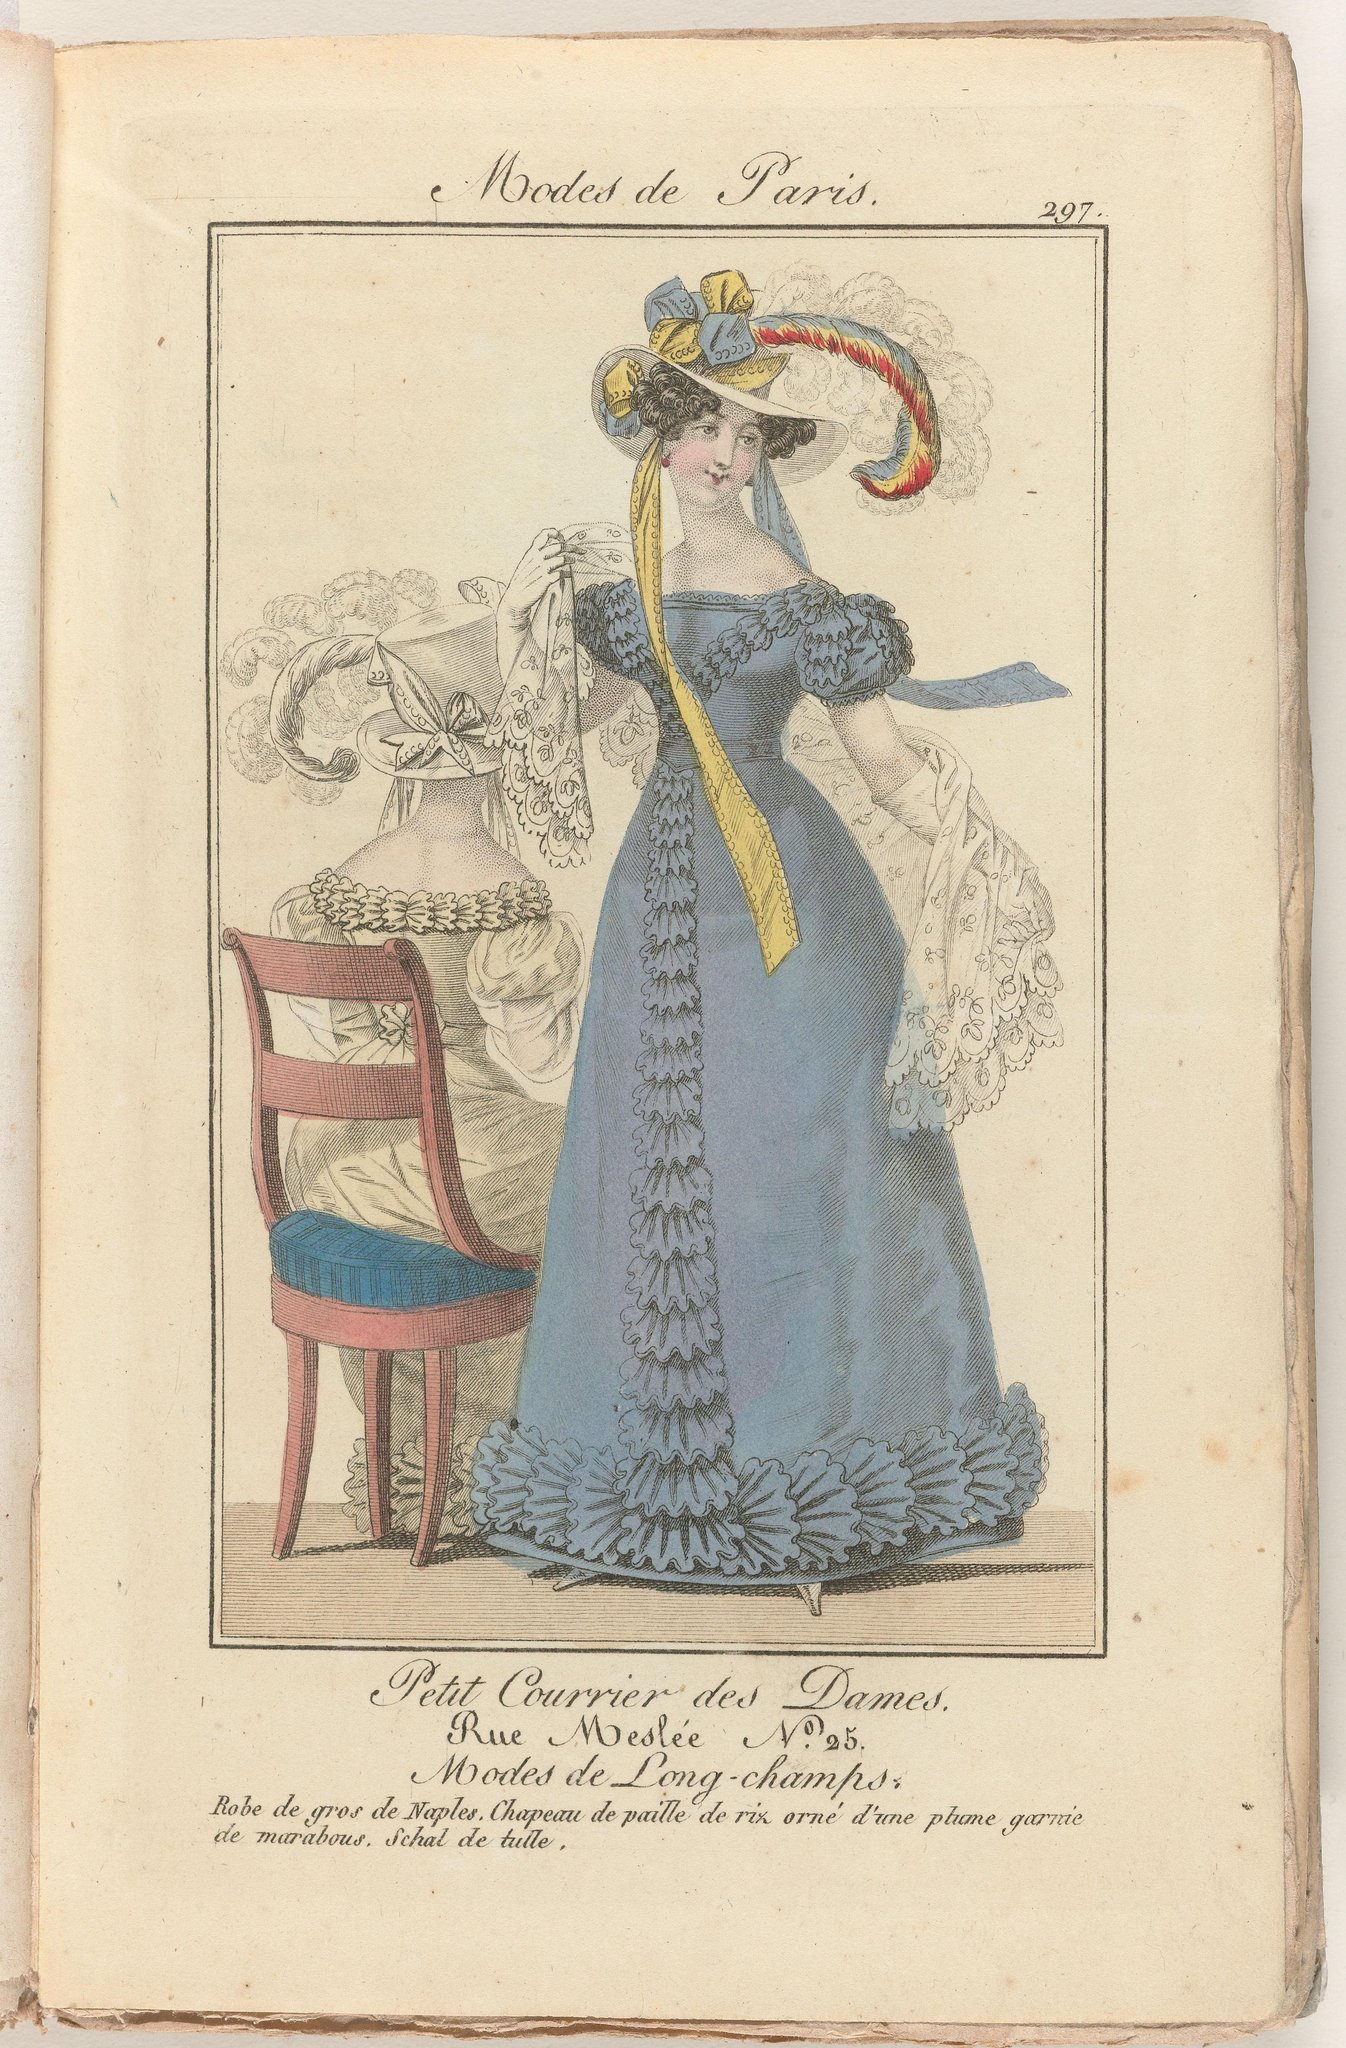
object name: magazine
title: Petit Courrier des Dames, ou Nouveau Journal des Modes, des Théatres, de la Litterature et des Arts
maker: Anonymous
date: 1825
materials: paper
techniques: engraving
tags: fashion plates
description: Prent uit het modetijdschrift Petit Courrier des Dames (1821-1868).